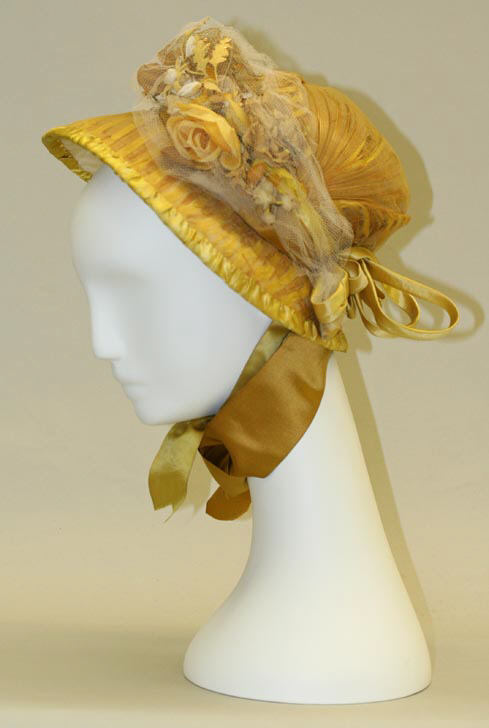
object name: bonnet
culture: american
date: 1800-1810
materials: silk, fiber